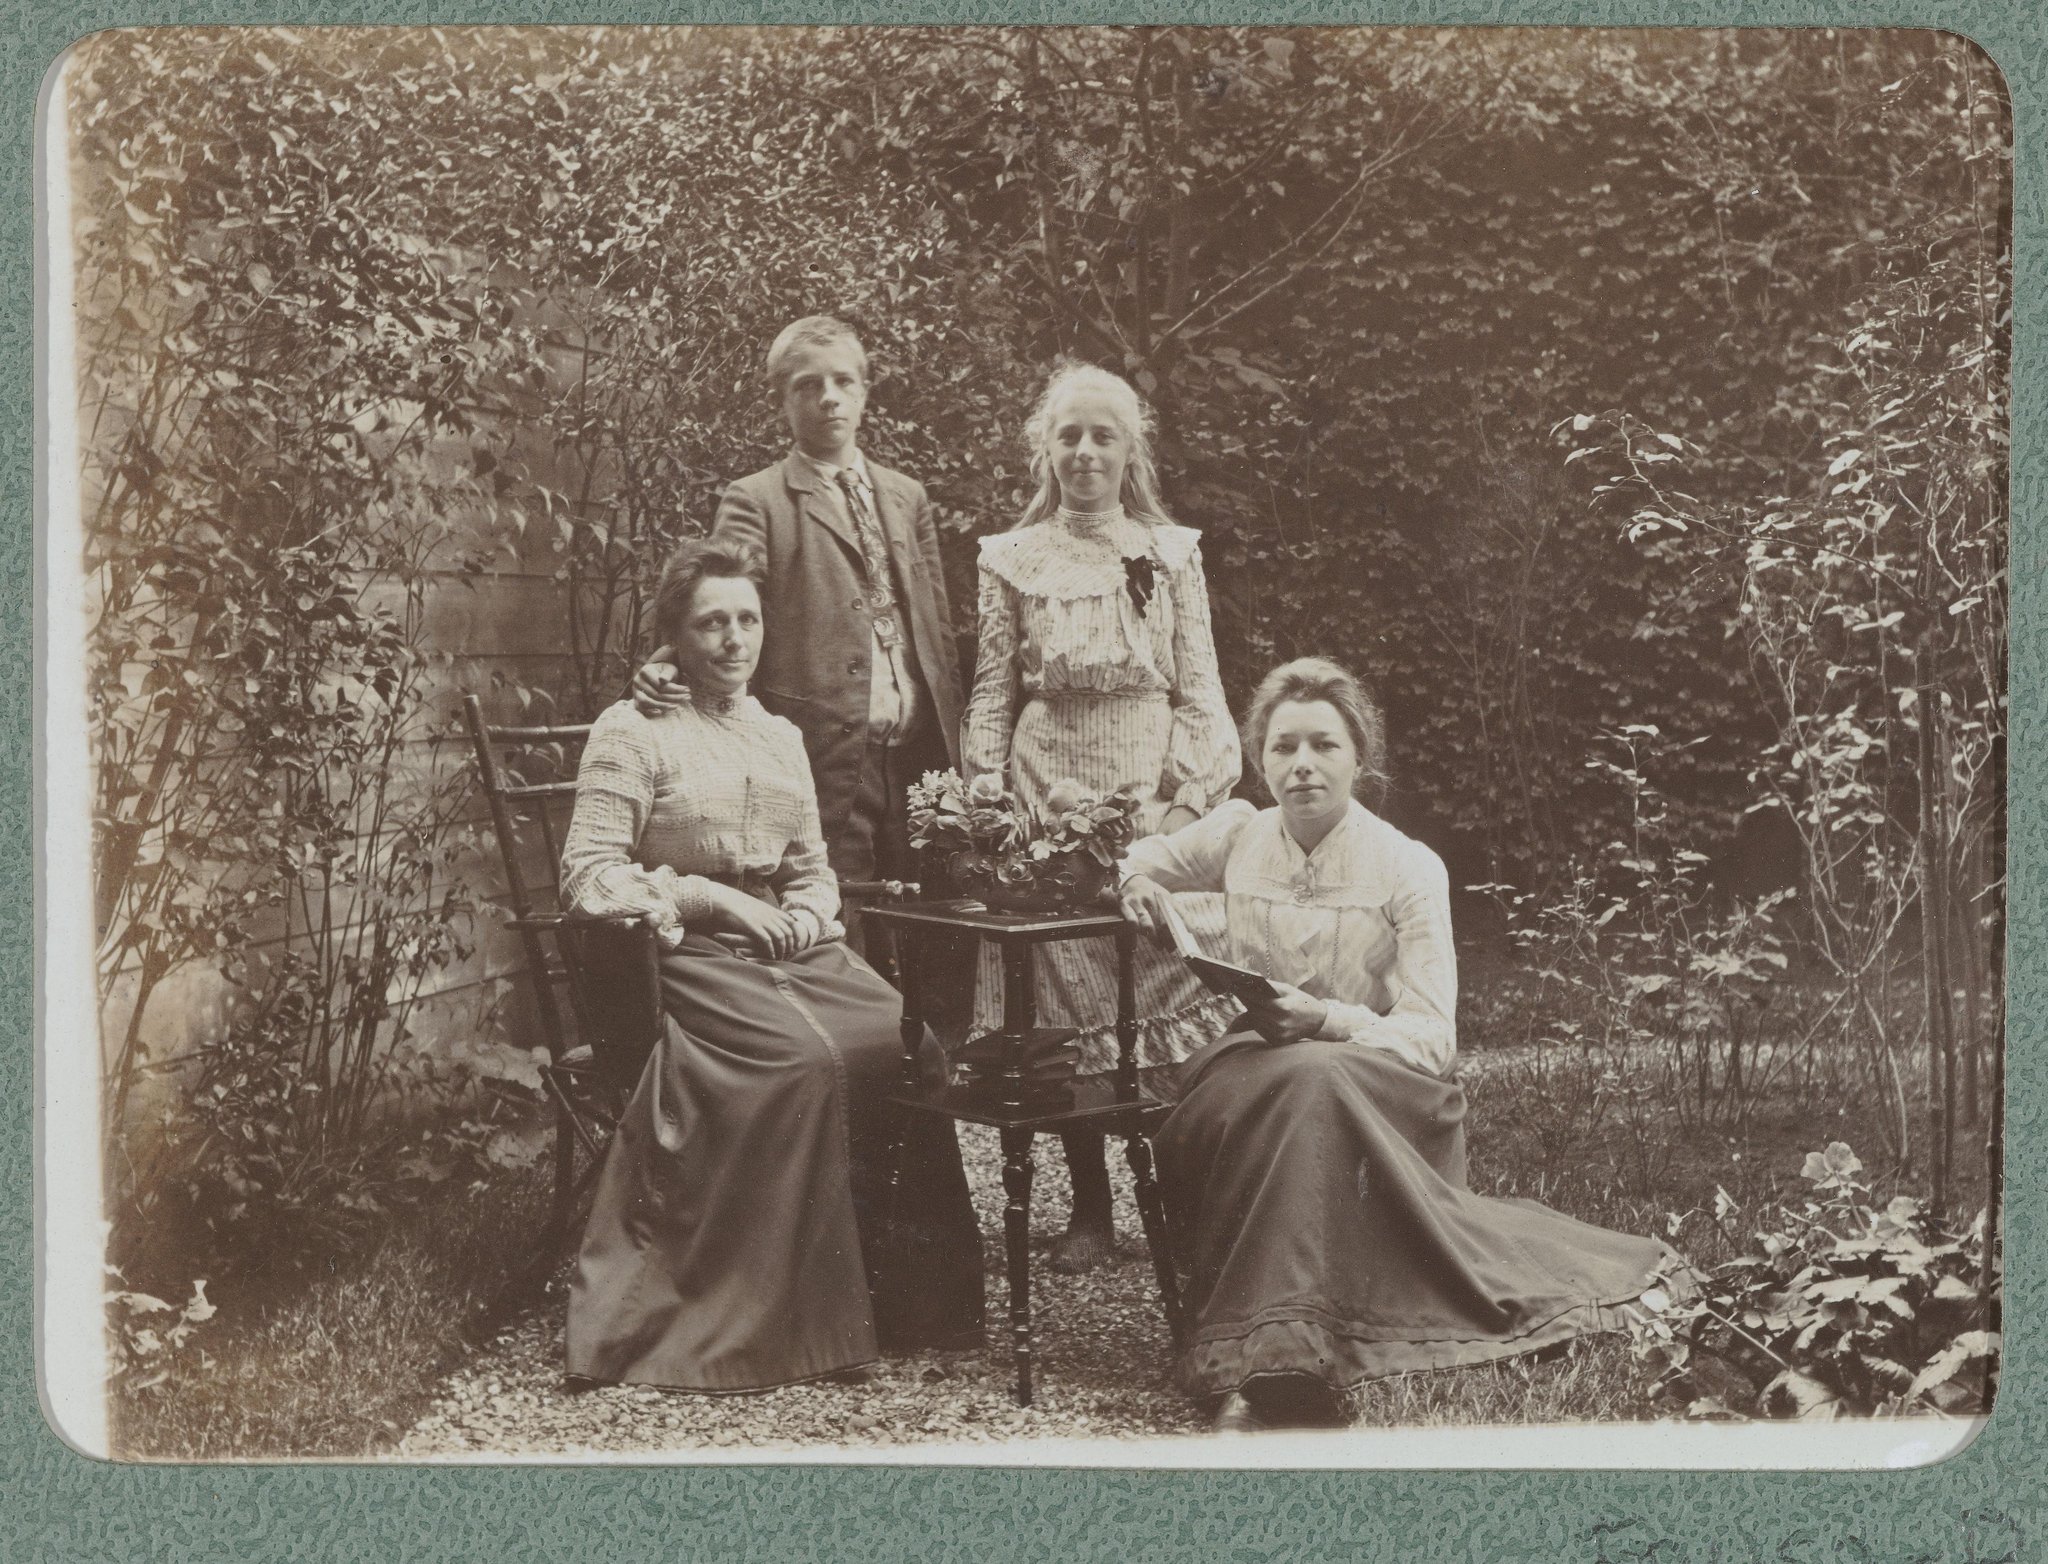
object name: album leaf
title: Groepsportret van twee vrouwen en twee kinderen in een tuin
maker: christiaan otto roelofs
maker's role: fotograaf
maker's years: 1882-1970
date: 1900-1915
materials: paper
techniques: albumen print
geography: netherlands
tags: boy (child between toddler and youth), historical persons, girl (child between toddler and youth), adult woman (+ two persons)